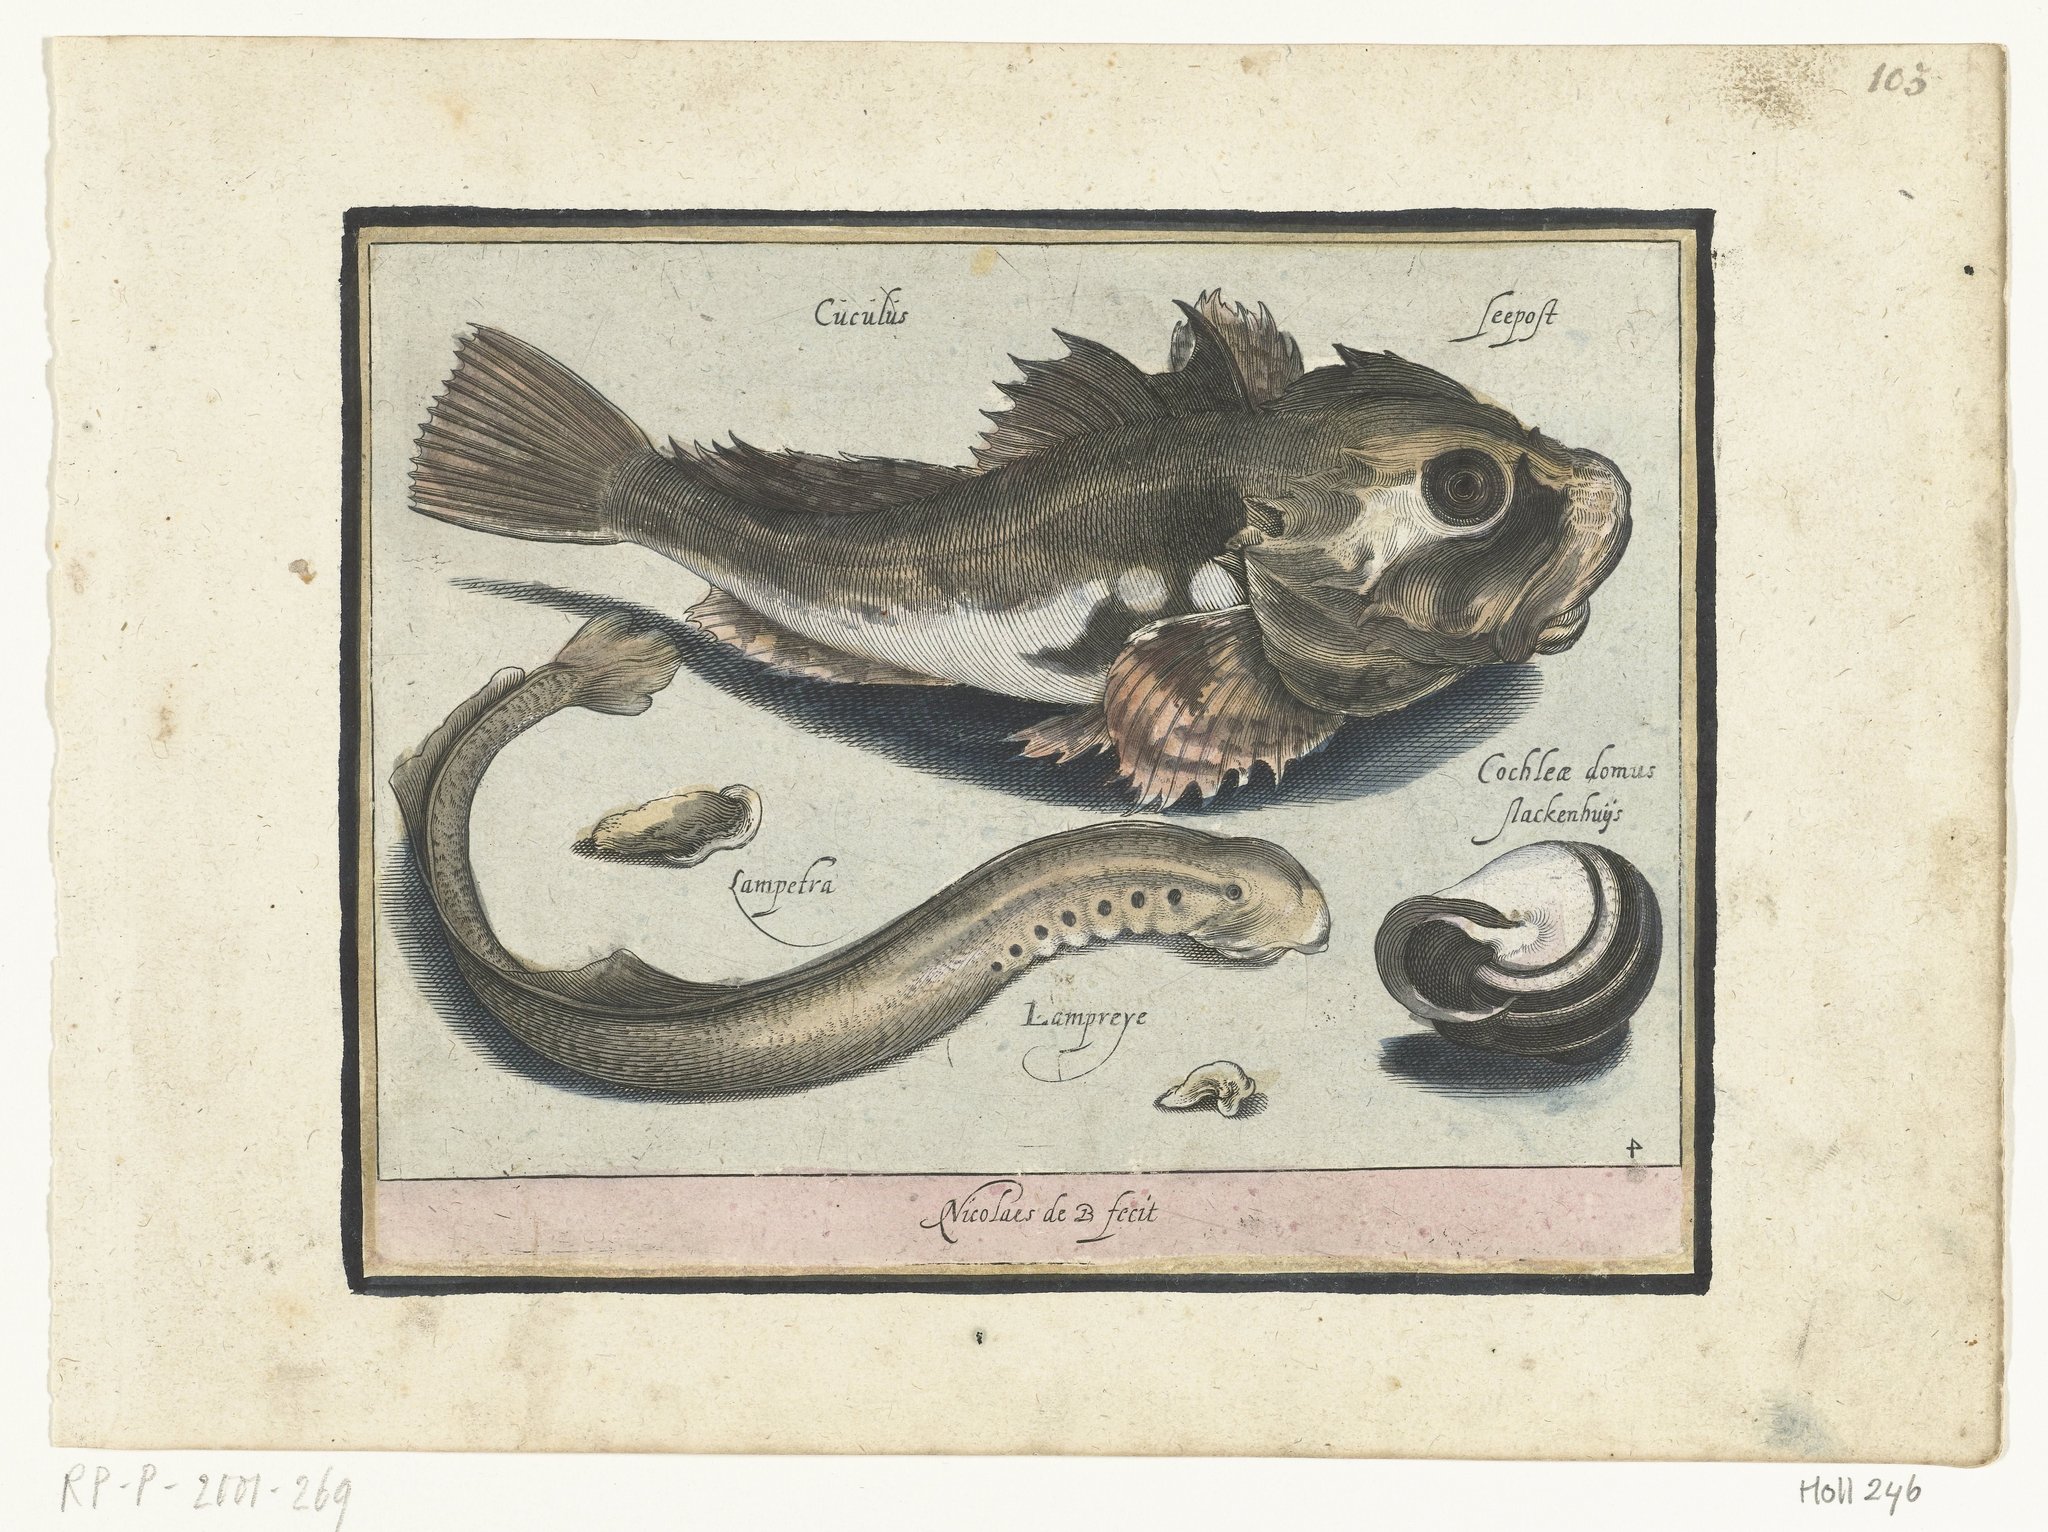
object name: print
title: Poon, prik en slakkehuis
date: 1581-1656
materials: paper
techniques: engraving, hand coloring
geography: netherlands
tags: fishes, animals (+ shell, snail-shell etc.)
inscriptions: collector's mark: Lugt 2760, collector's mark: Lugt 2228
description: Prent uit serie Libelivs varia Genera piscium complectens van dertien prenten met zoetwatervissen, zeevissen, kikkers, schaaldieren en zeewezens (inclusief titelprent).